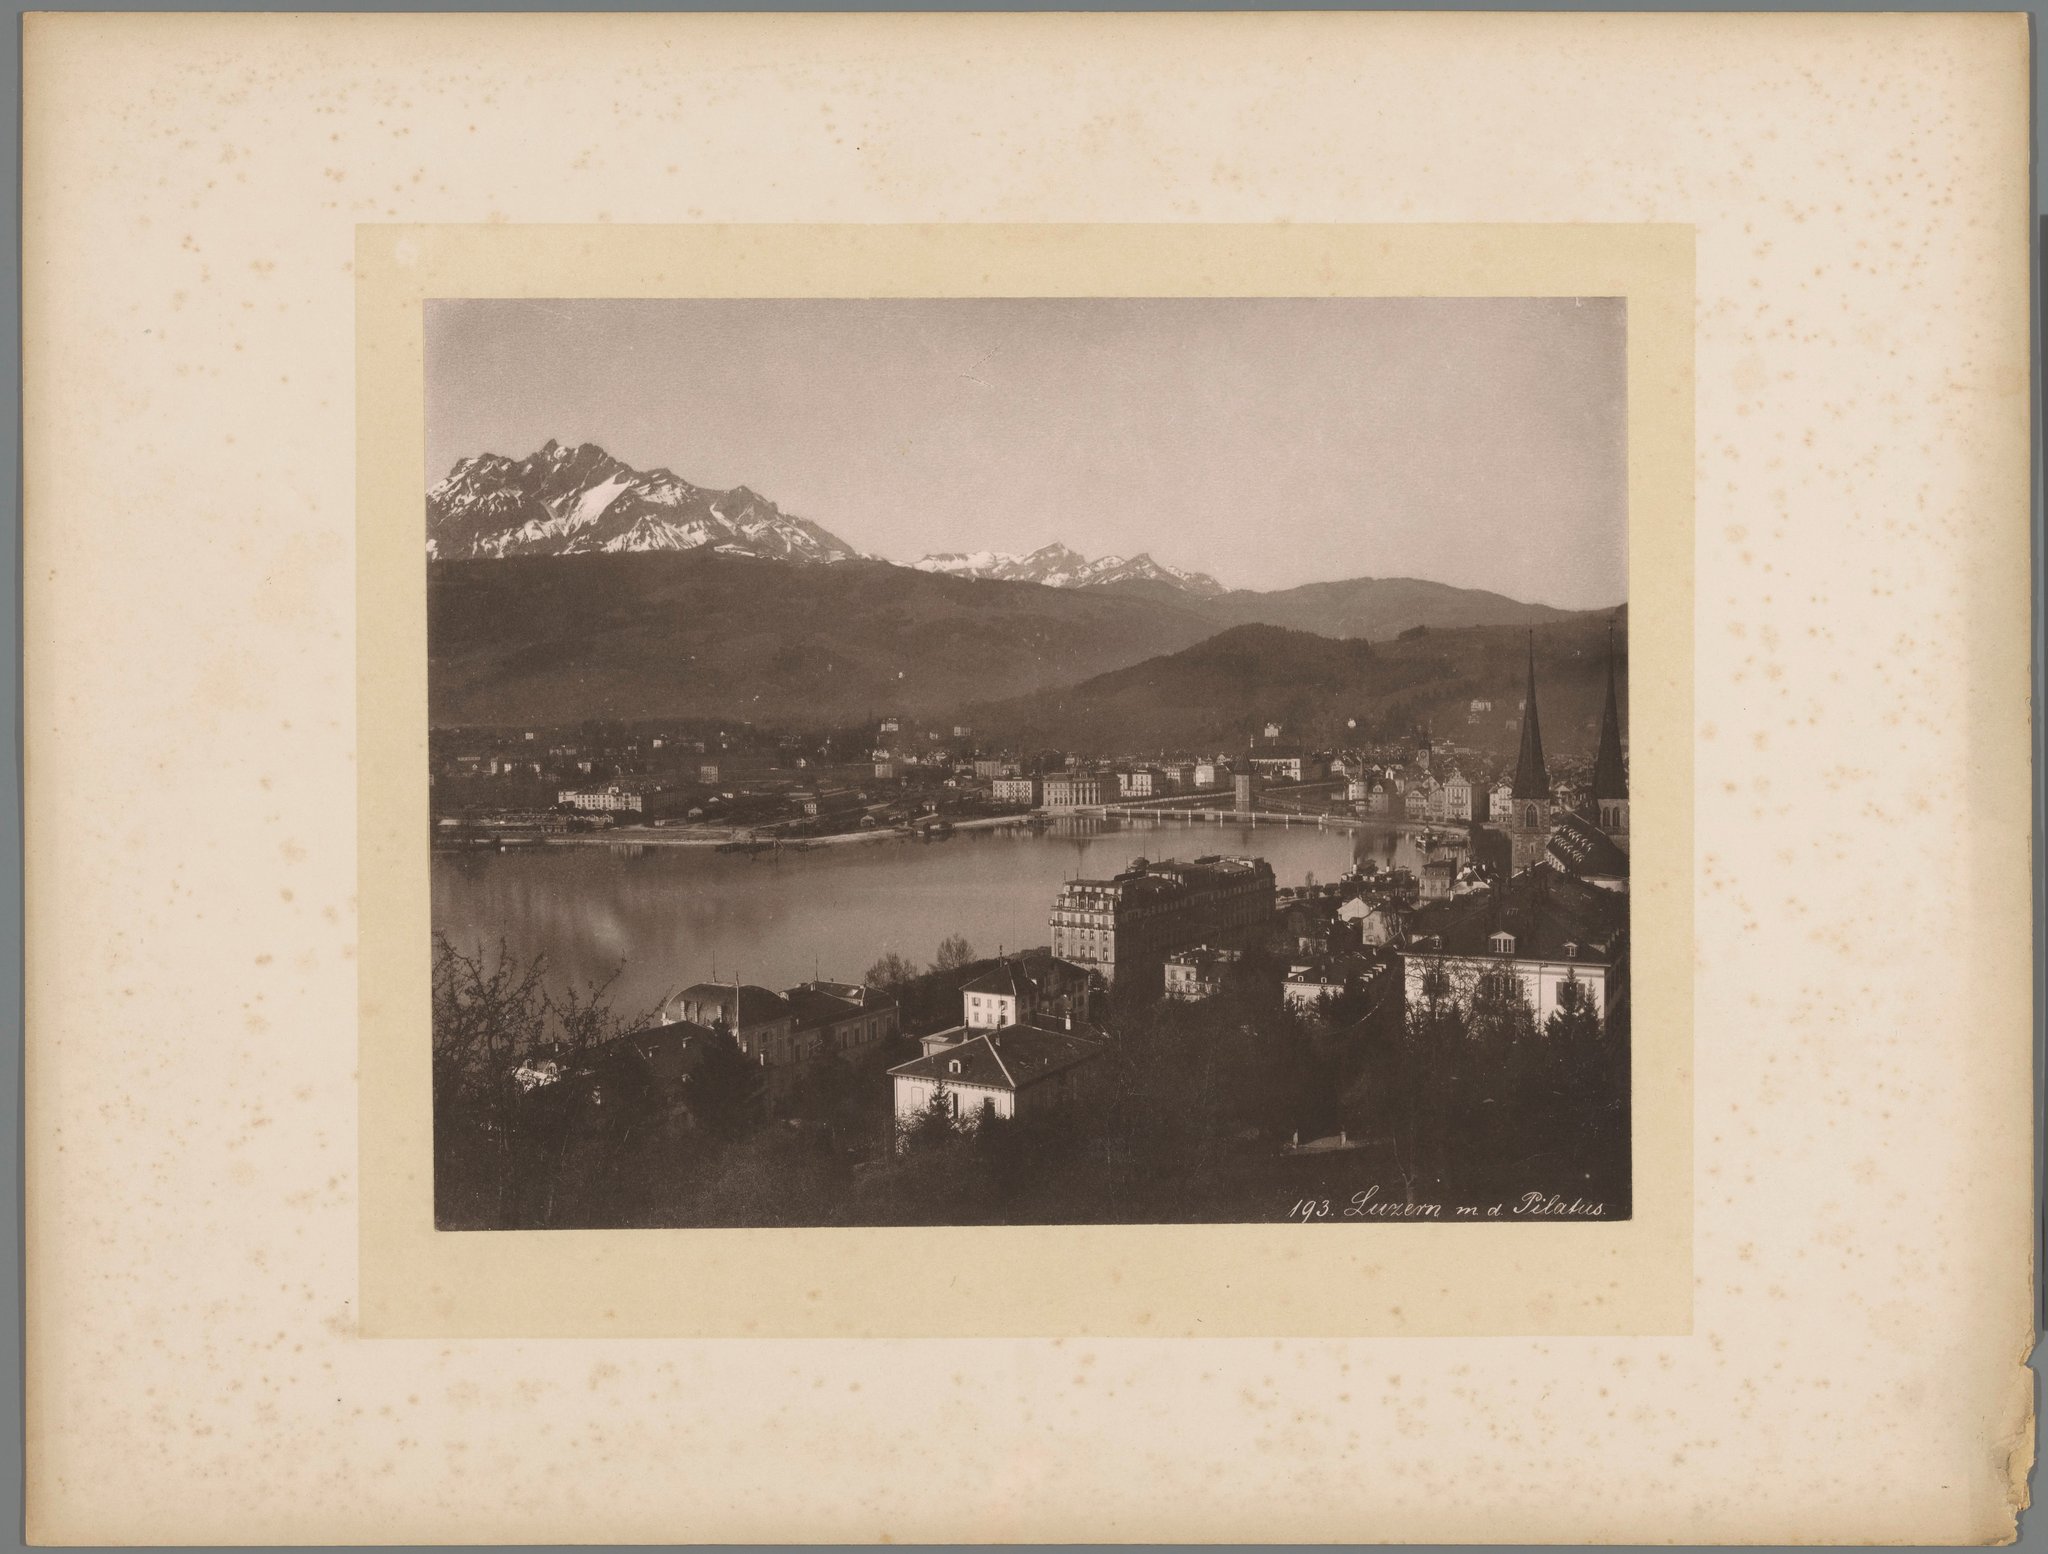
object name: photomechanical print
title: Gezicht op Luzern, in de verte de Pilatus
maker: Anonymous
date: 1870-1930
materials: cardboard, paper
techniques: photograph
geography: lucerne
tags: city-view in general; 'veduta', mountains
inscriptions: number: ‘193.’